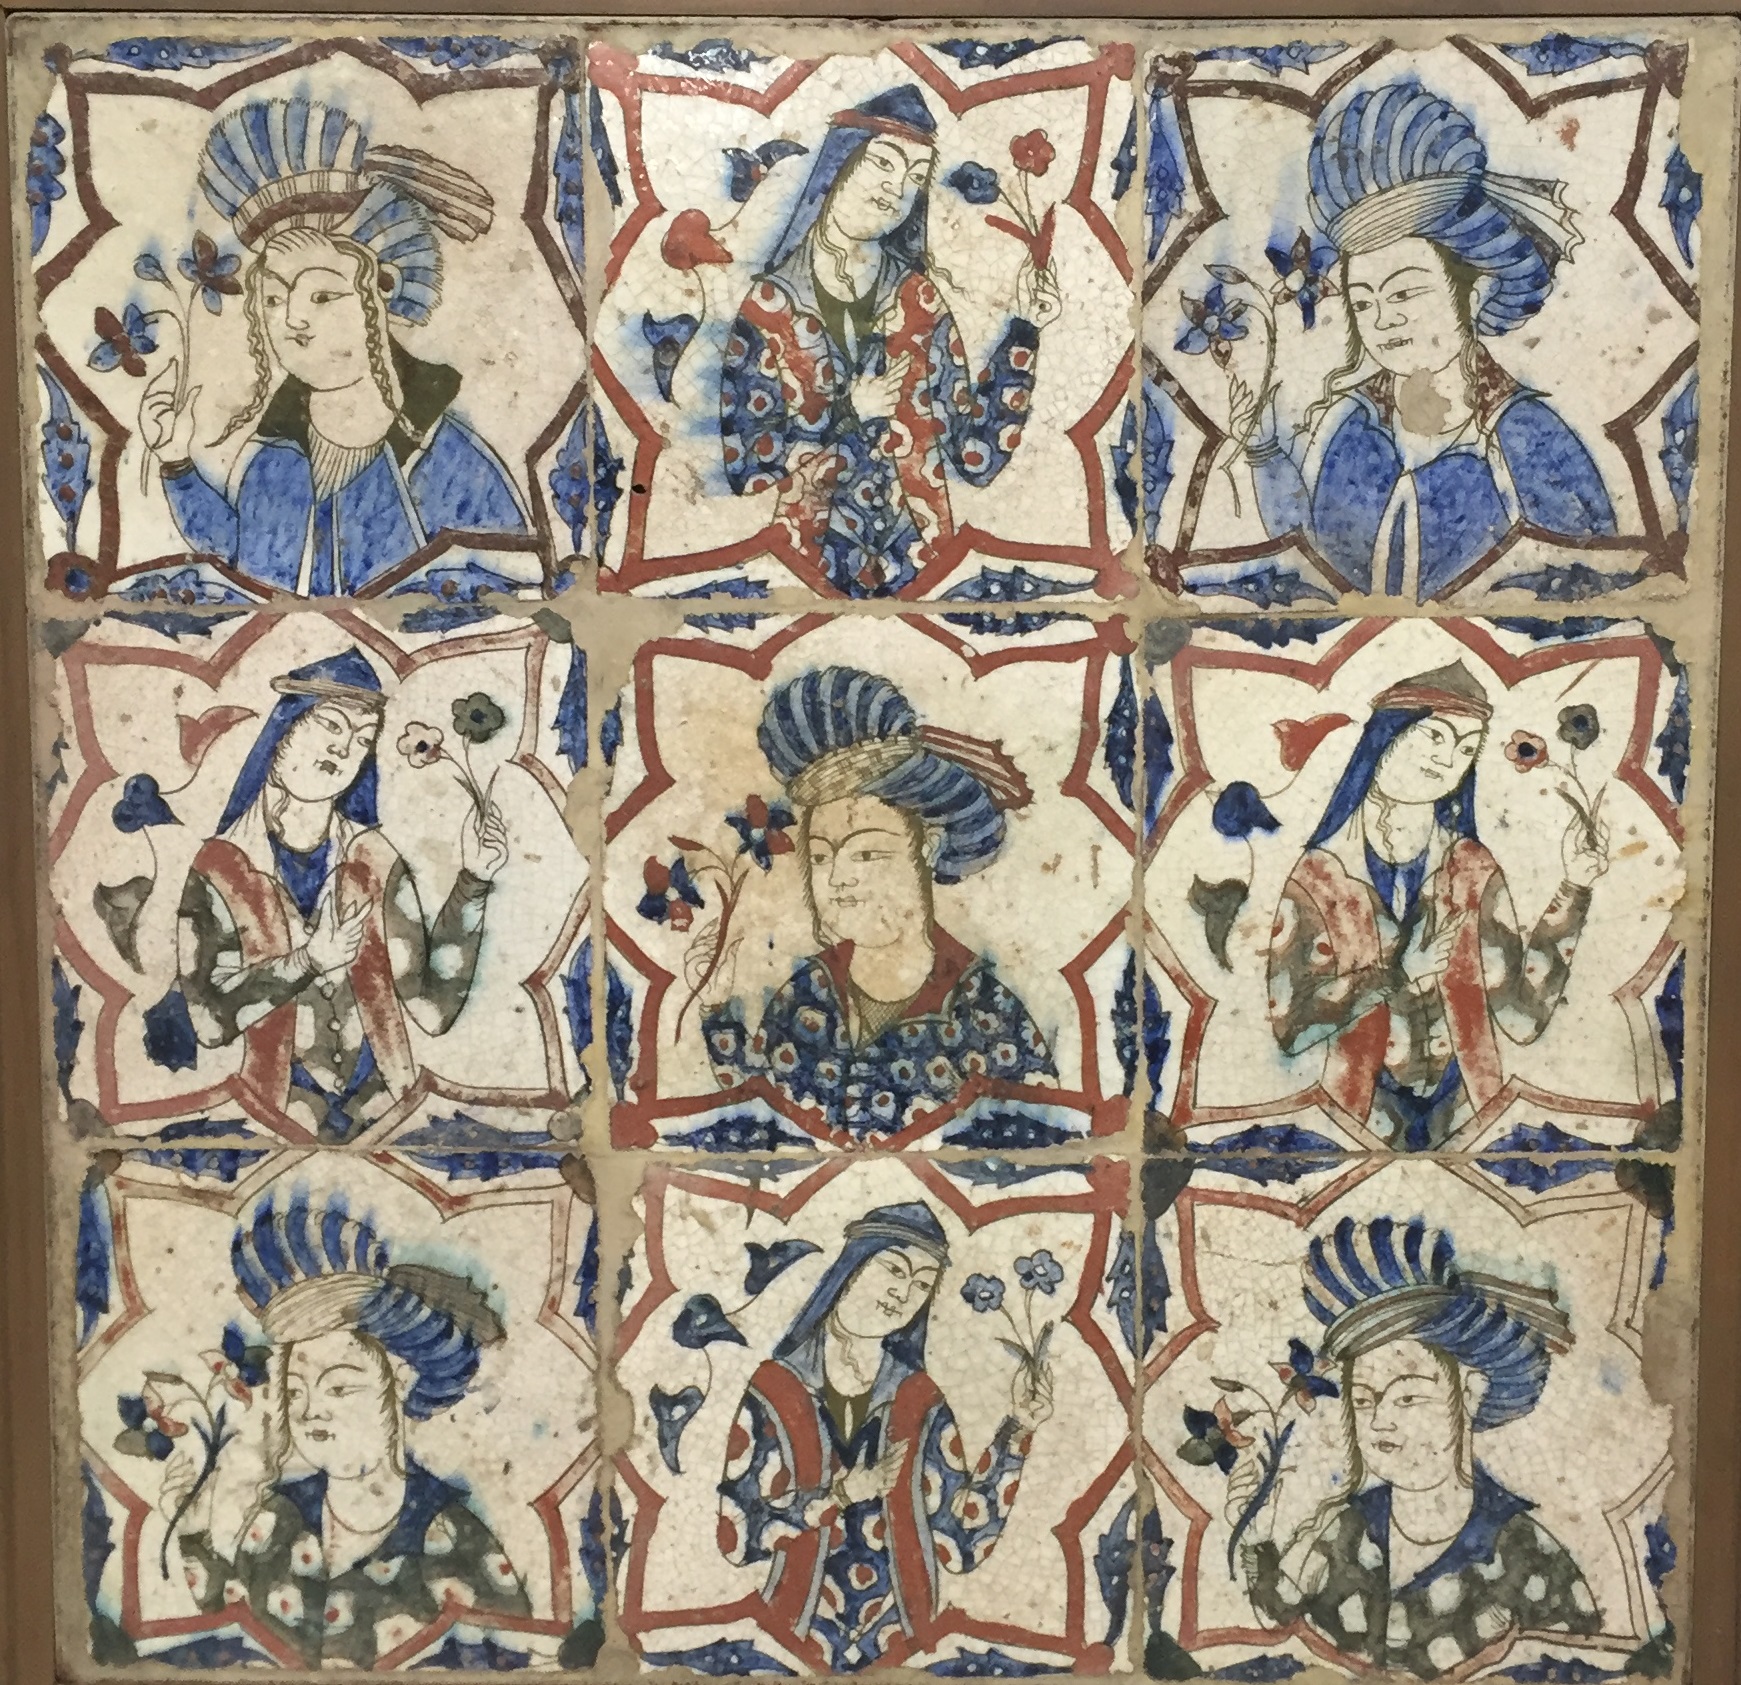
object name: tile panel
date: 1601-1700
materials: glaze, stonepaste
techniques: painting, polychrome, underglaze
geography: caucasus or iran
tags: women